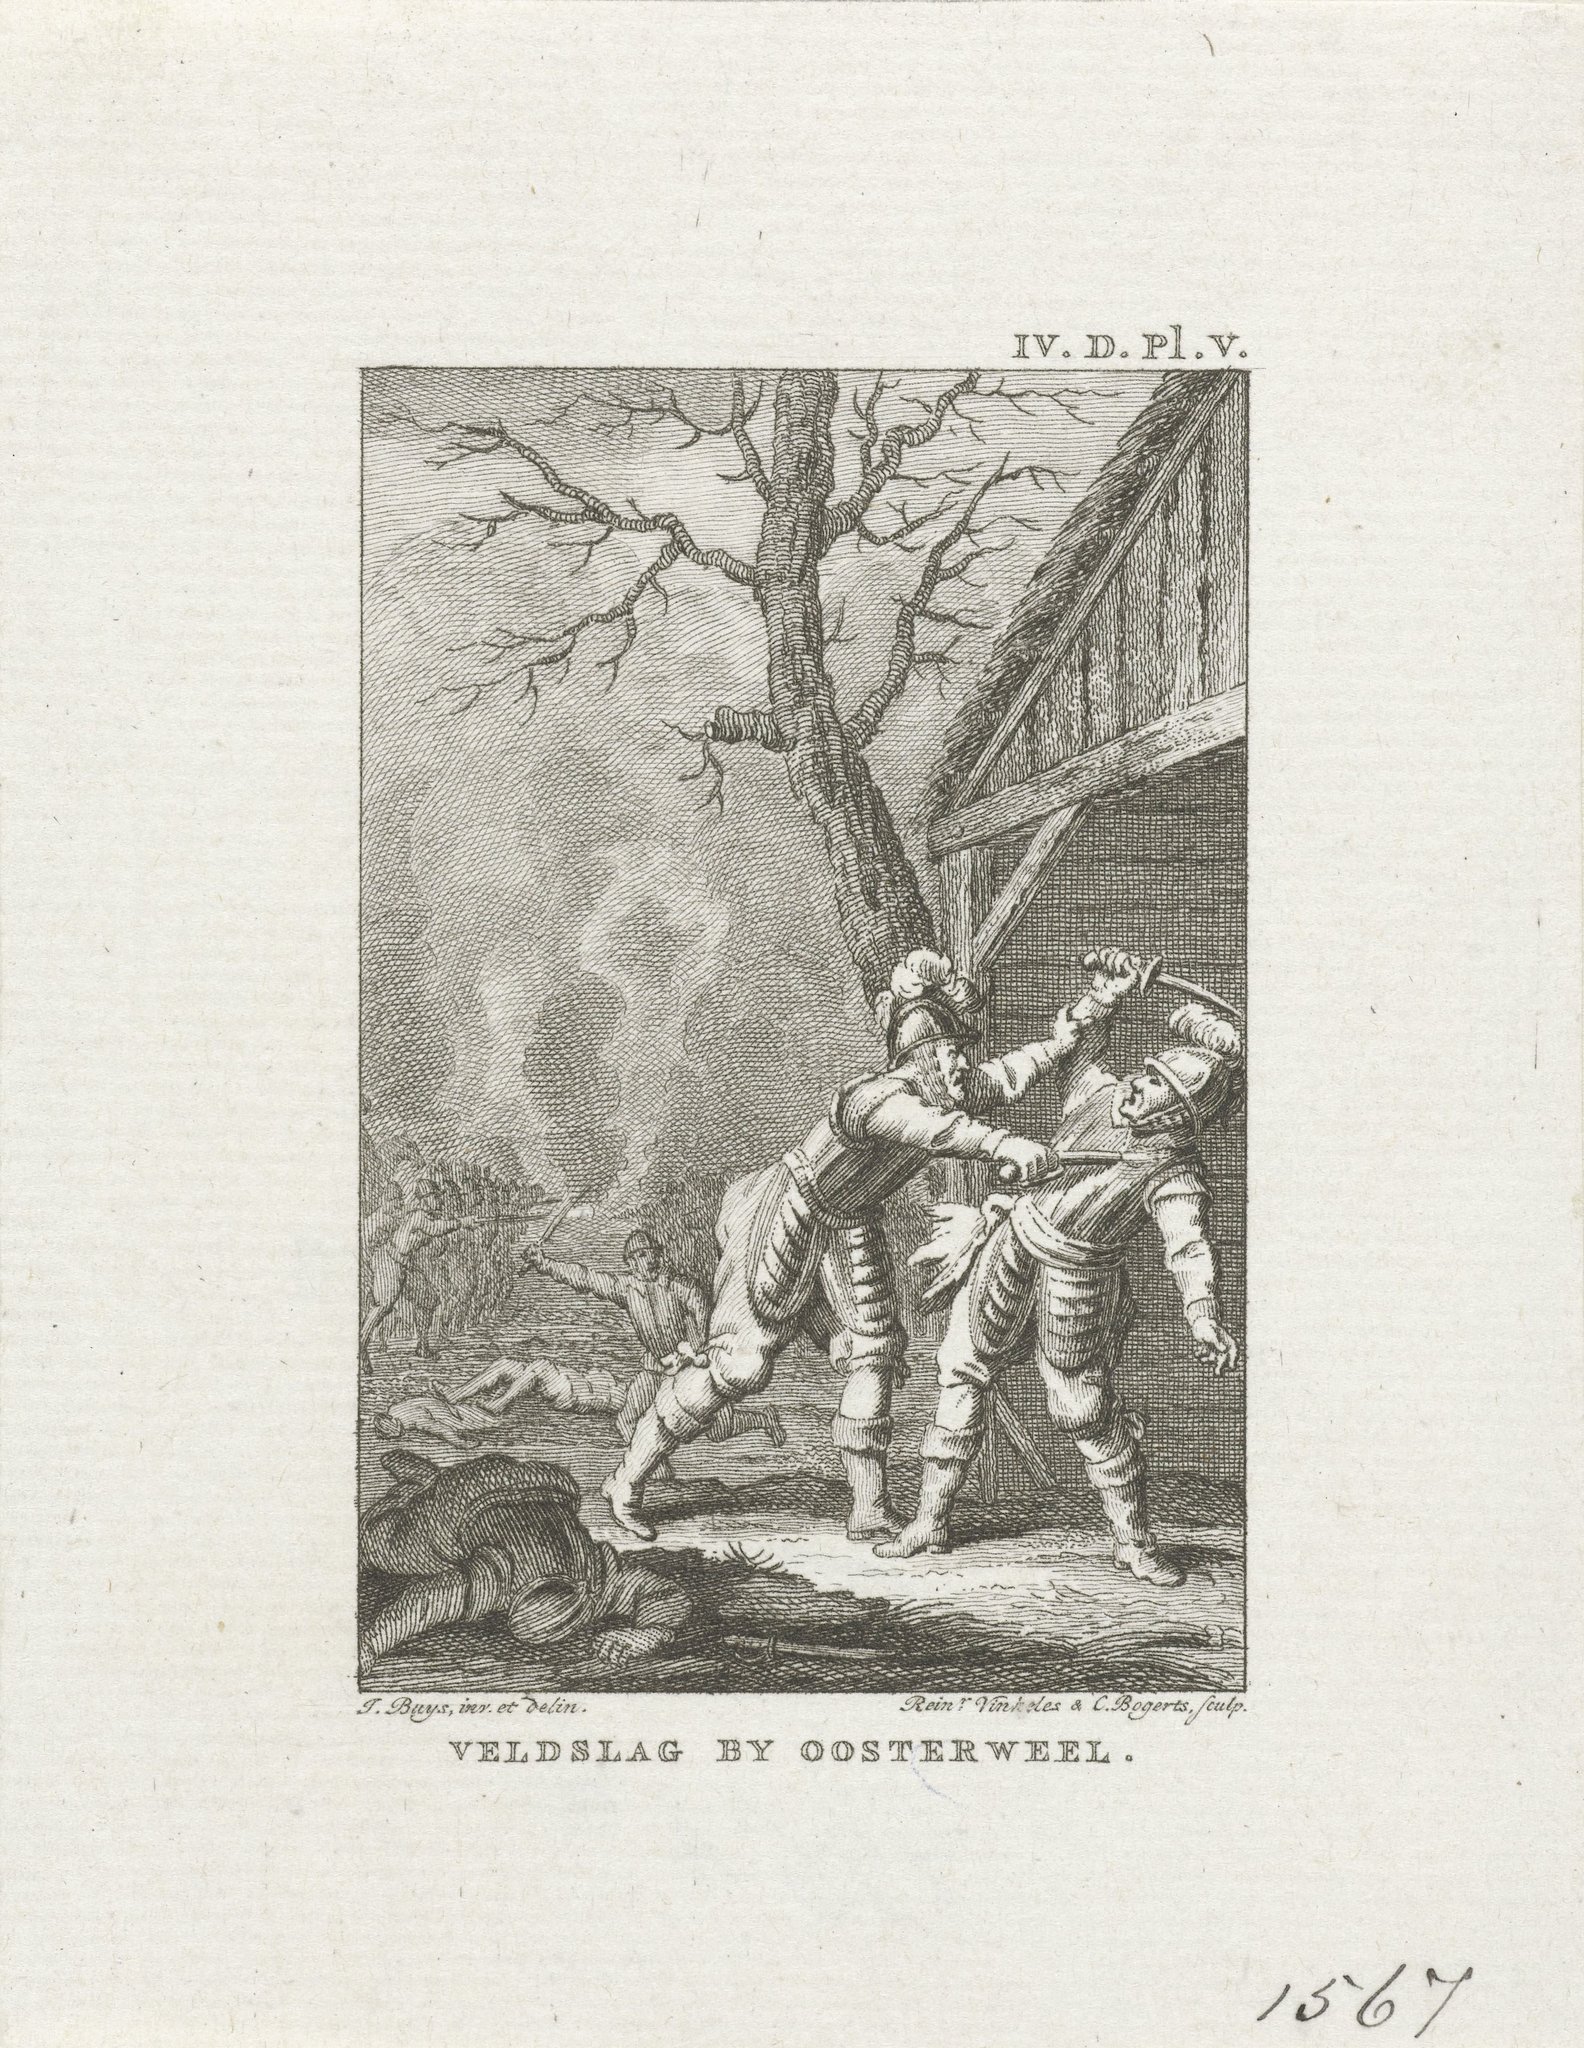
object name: history print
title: Veldslag bij Oosterweel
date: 1780-1795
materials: paper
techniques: etching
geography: netherlands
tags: battle, fighting in general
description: Illustratie voor: J. Fokke, Geschiedenissen der Vereenigde Nederlanden voor de vaderlandsche jeugd, Johannes Allart, Amsterdam 1783-1795, 25 delen, dl. IV, pl. V. Niet in Frederik Muller; door het RPK toegevoegd nummer. Staat met de letter.